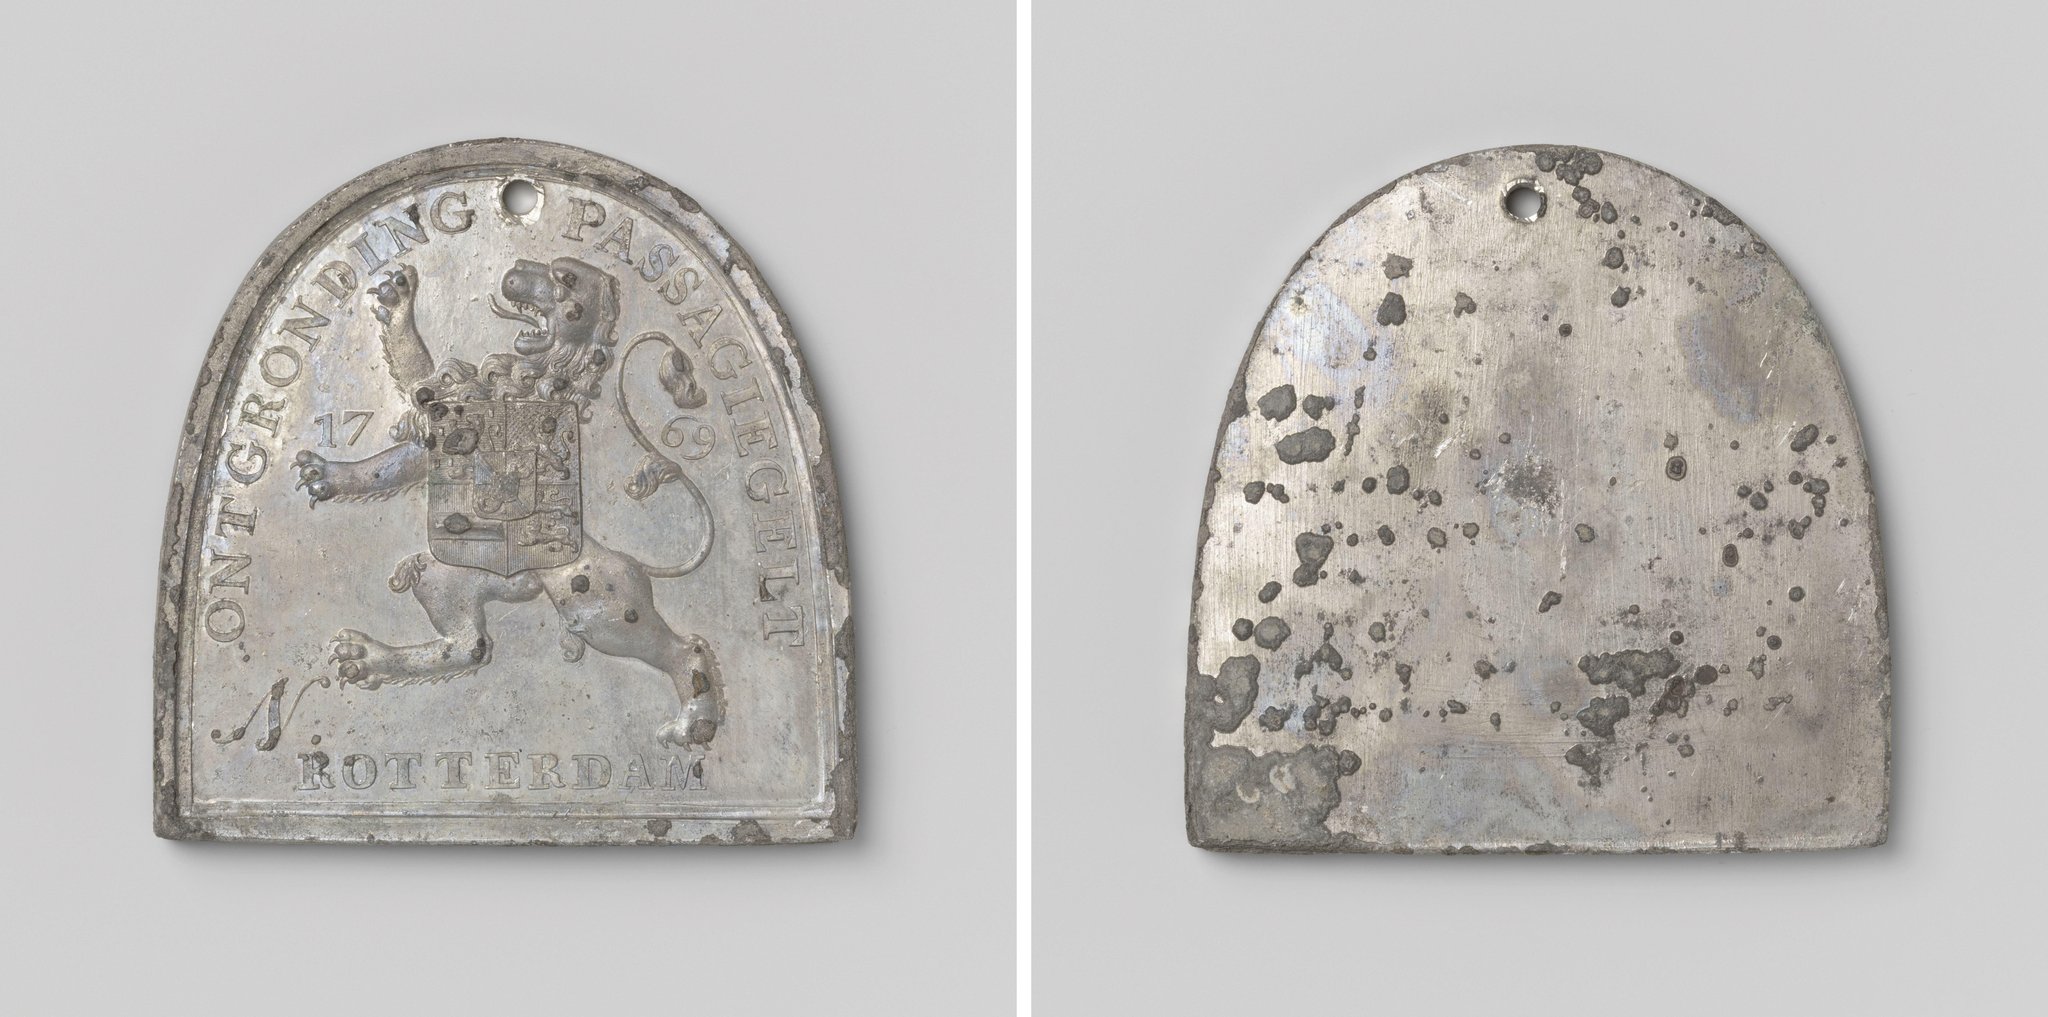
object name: ontgrondingspenning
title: Ontgronding te Rotterdam, penning bedoeld als bewijs voor turfdragers, -vullers of -tonners om turf in te mogen voeren uit de nieuw ontgronde venen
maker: Anonymous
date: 1769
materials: lead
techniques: casting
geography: rotterdam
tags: rotterdam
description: Eenzijdige loden penning met ronde boven- en rechthoekige onderzijde, en gat erin. Voorzijde: staande leeuw met wapenschild op borst tussen jaartal binnen omschrift. Keerzijde: blanco.